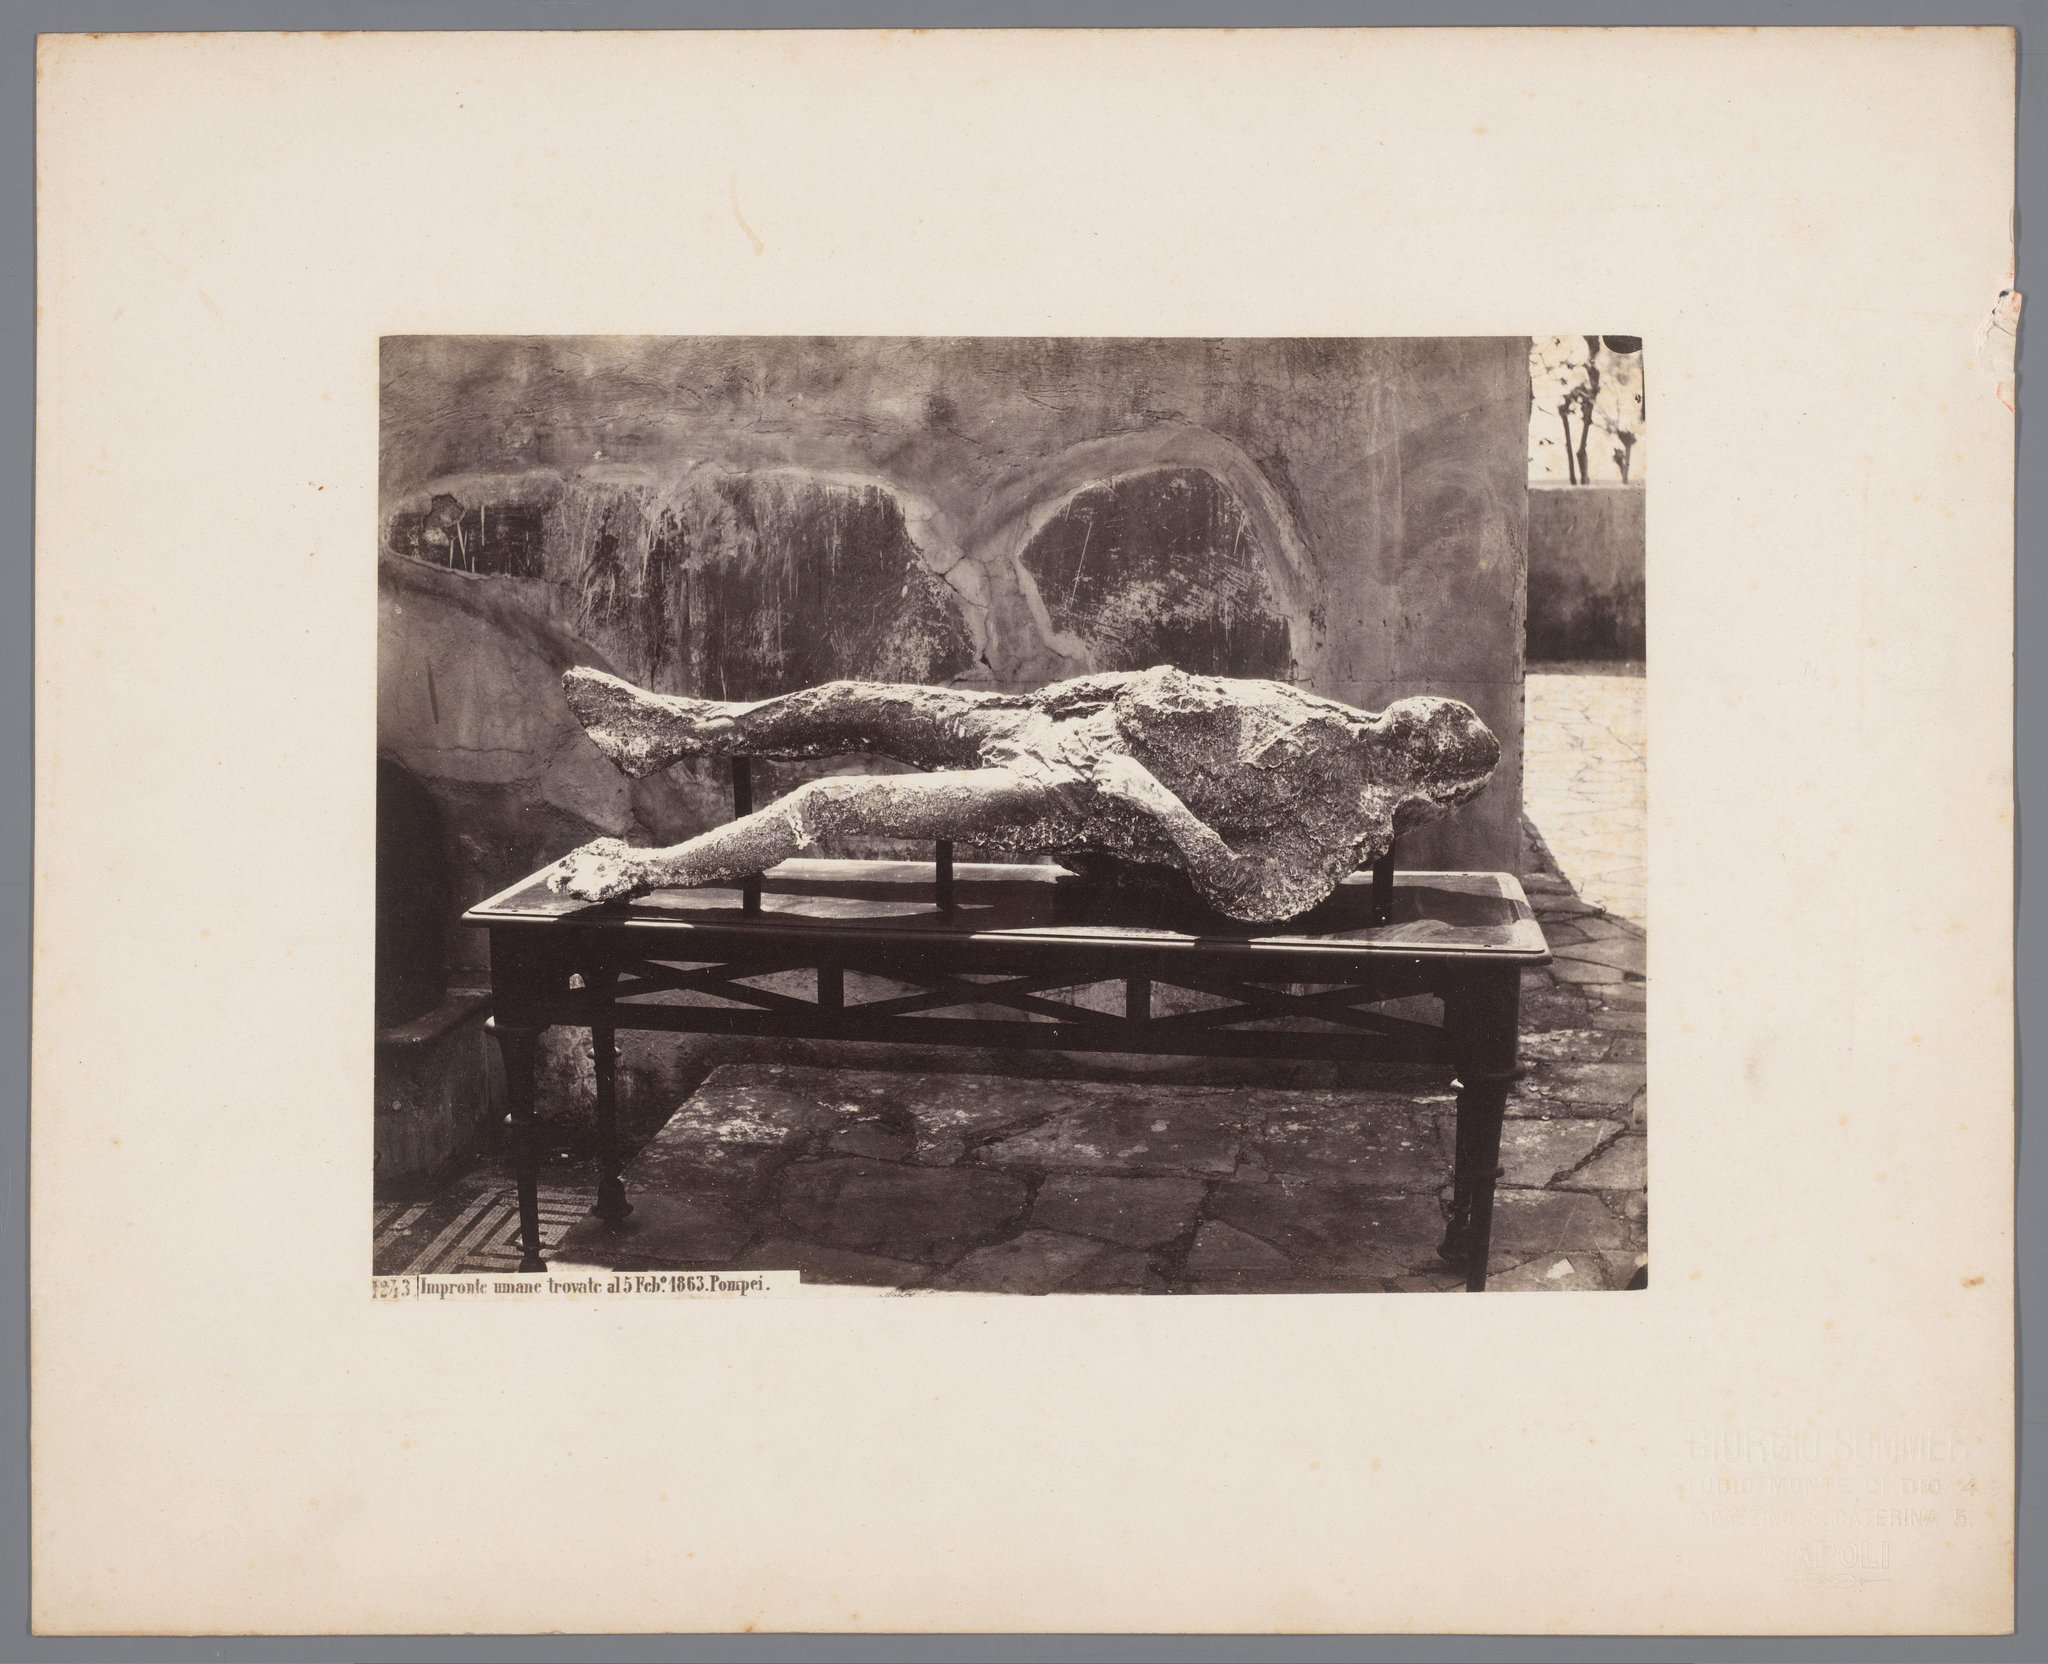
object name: photograph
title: Impronte umane trovate al 5 feb. 1863, Pompei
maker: giorgio sommer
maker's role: fotograaf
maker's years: 1834-1914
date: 1856-1875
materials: cardboard, paper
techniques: albumen print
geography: pompeii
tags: man in a general biological sense, pompeii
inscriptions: number: ‘1243.’, address: ‘GIORGIO SOMMER/ STUDIO MONTE DI DIO 4./ MAGAZZINO S. CATERINA 5./ NAPOLI’